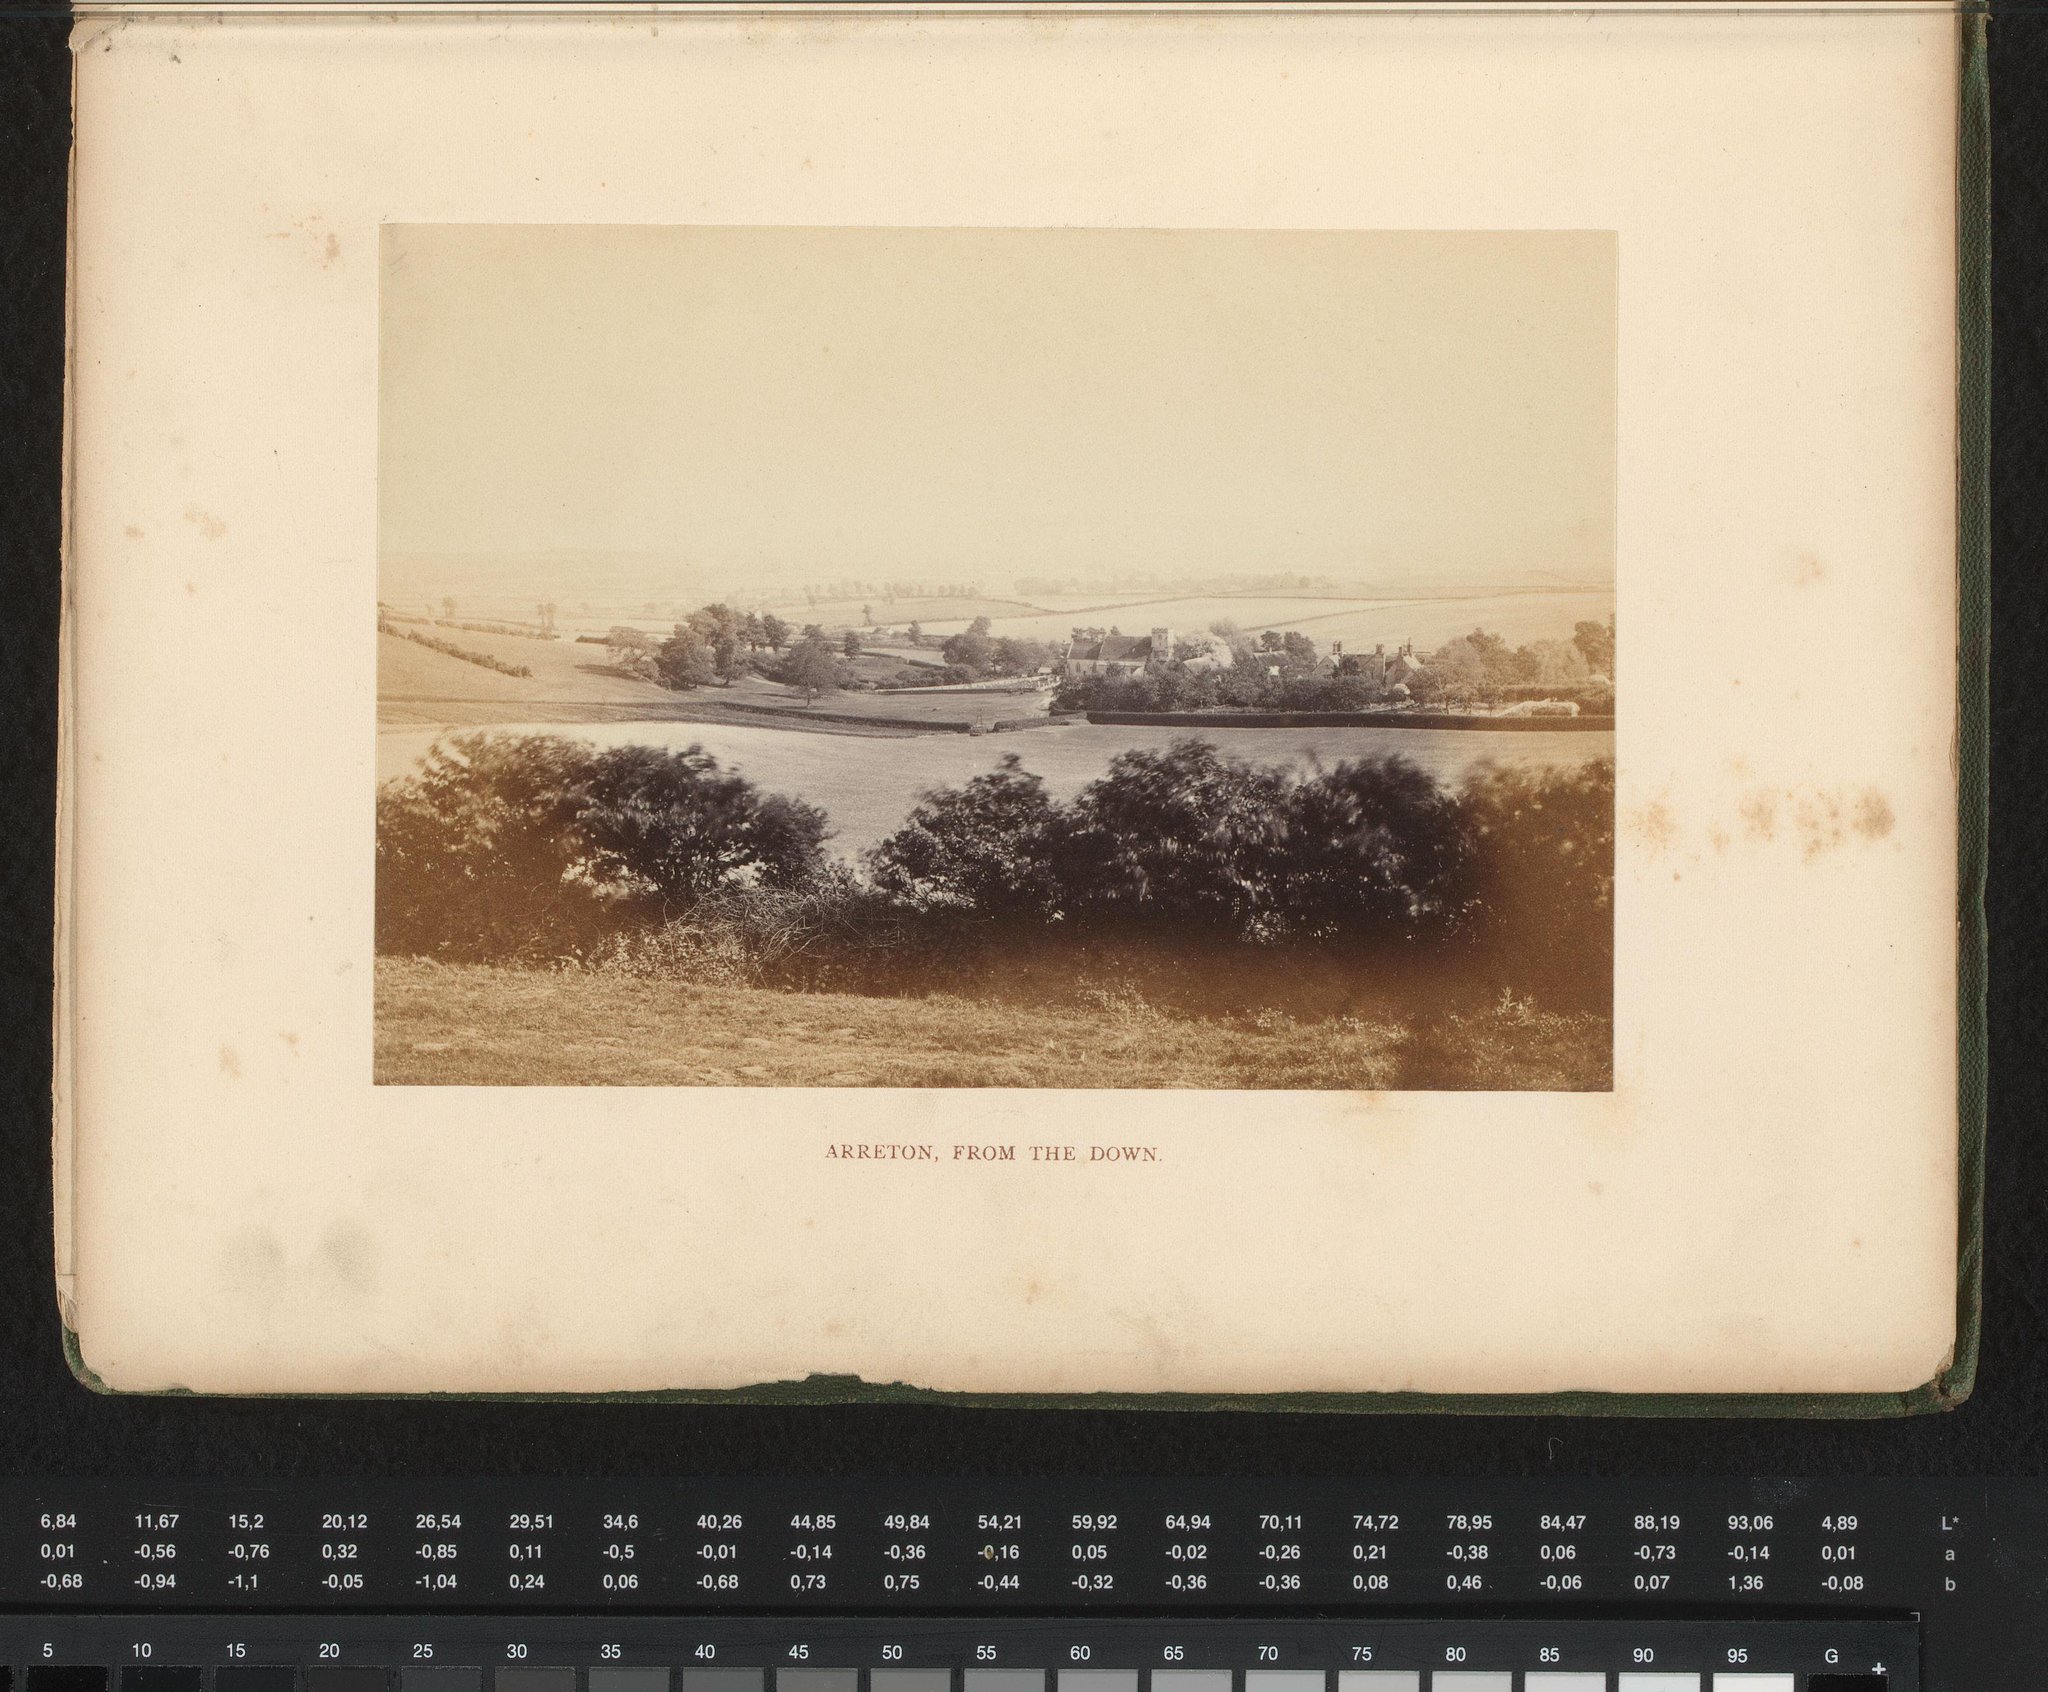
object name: photograph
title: Arreton, from the Down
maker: william russell sedgfield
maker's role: fotograaf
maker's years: 1826-1902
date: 1864-1869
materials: paper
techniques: albumen print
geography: isle of wight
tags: dale, valley, city-view in general; 'veduta'